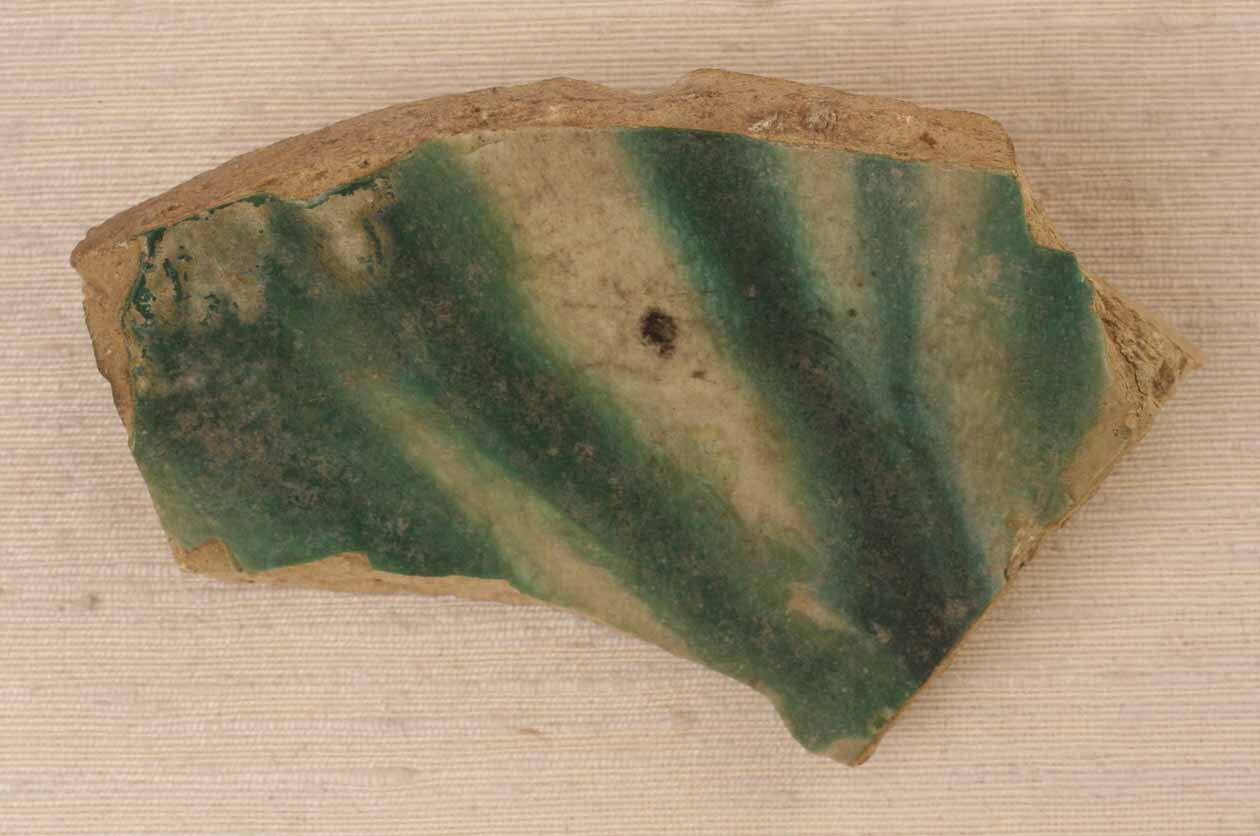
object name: fragment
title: Fragments of Splashed Ceramic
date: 801-900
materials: earthenware, glaze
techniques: painting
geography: iraq